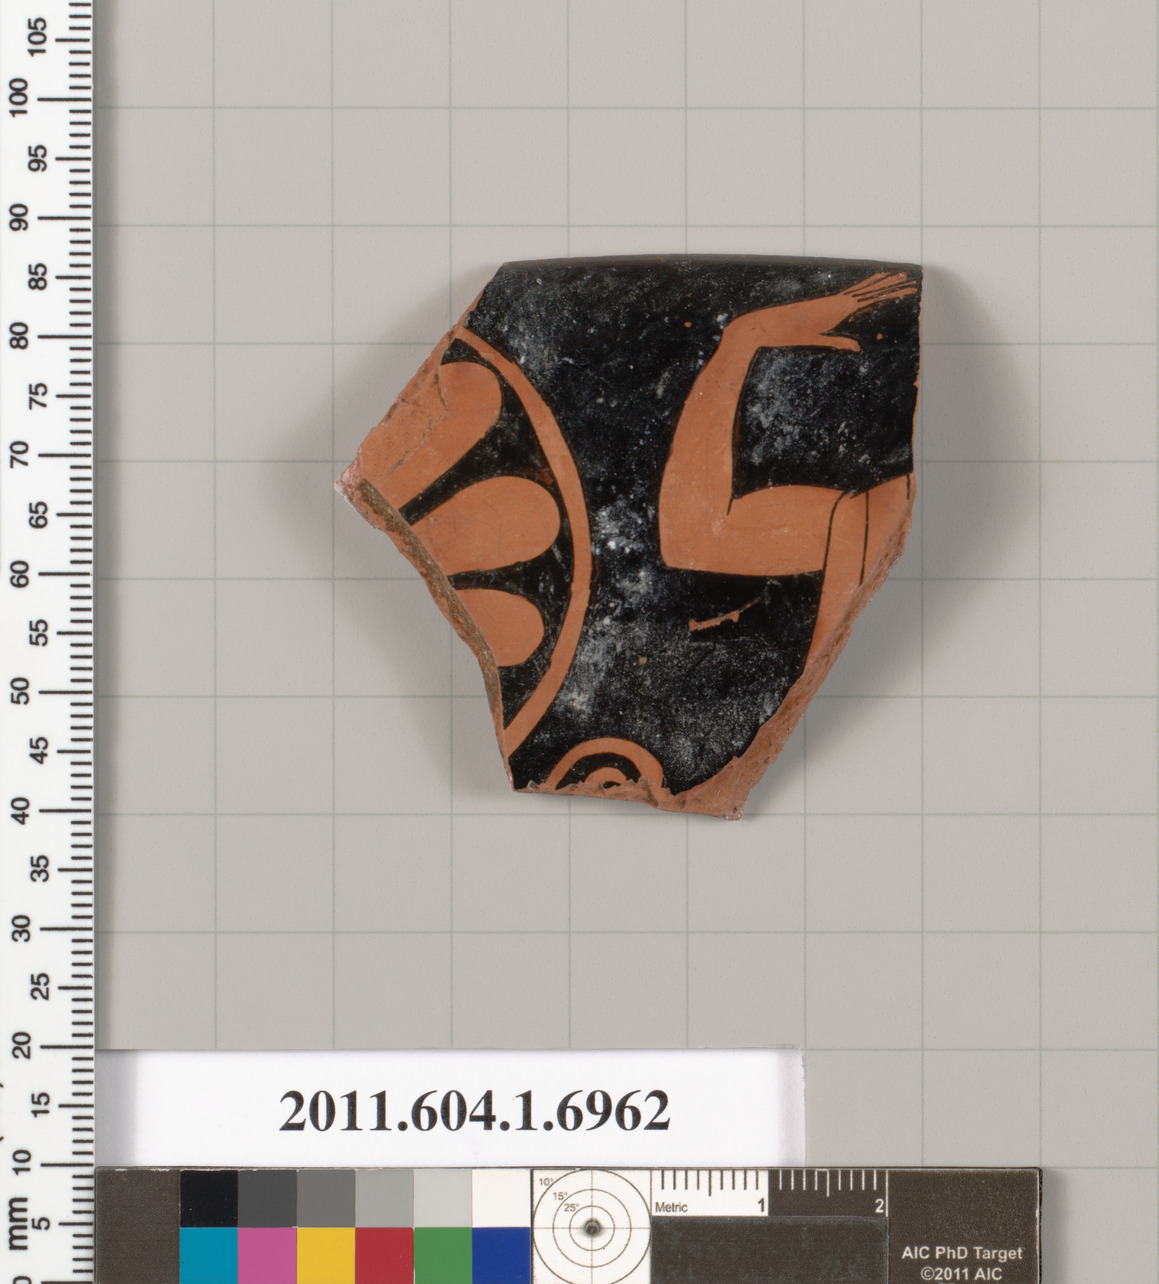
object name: kylix fragment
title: Terracotta rim fragment of a kylix (drinking cup)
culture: greek, attic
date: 490-470 BCE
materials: terracotta